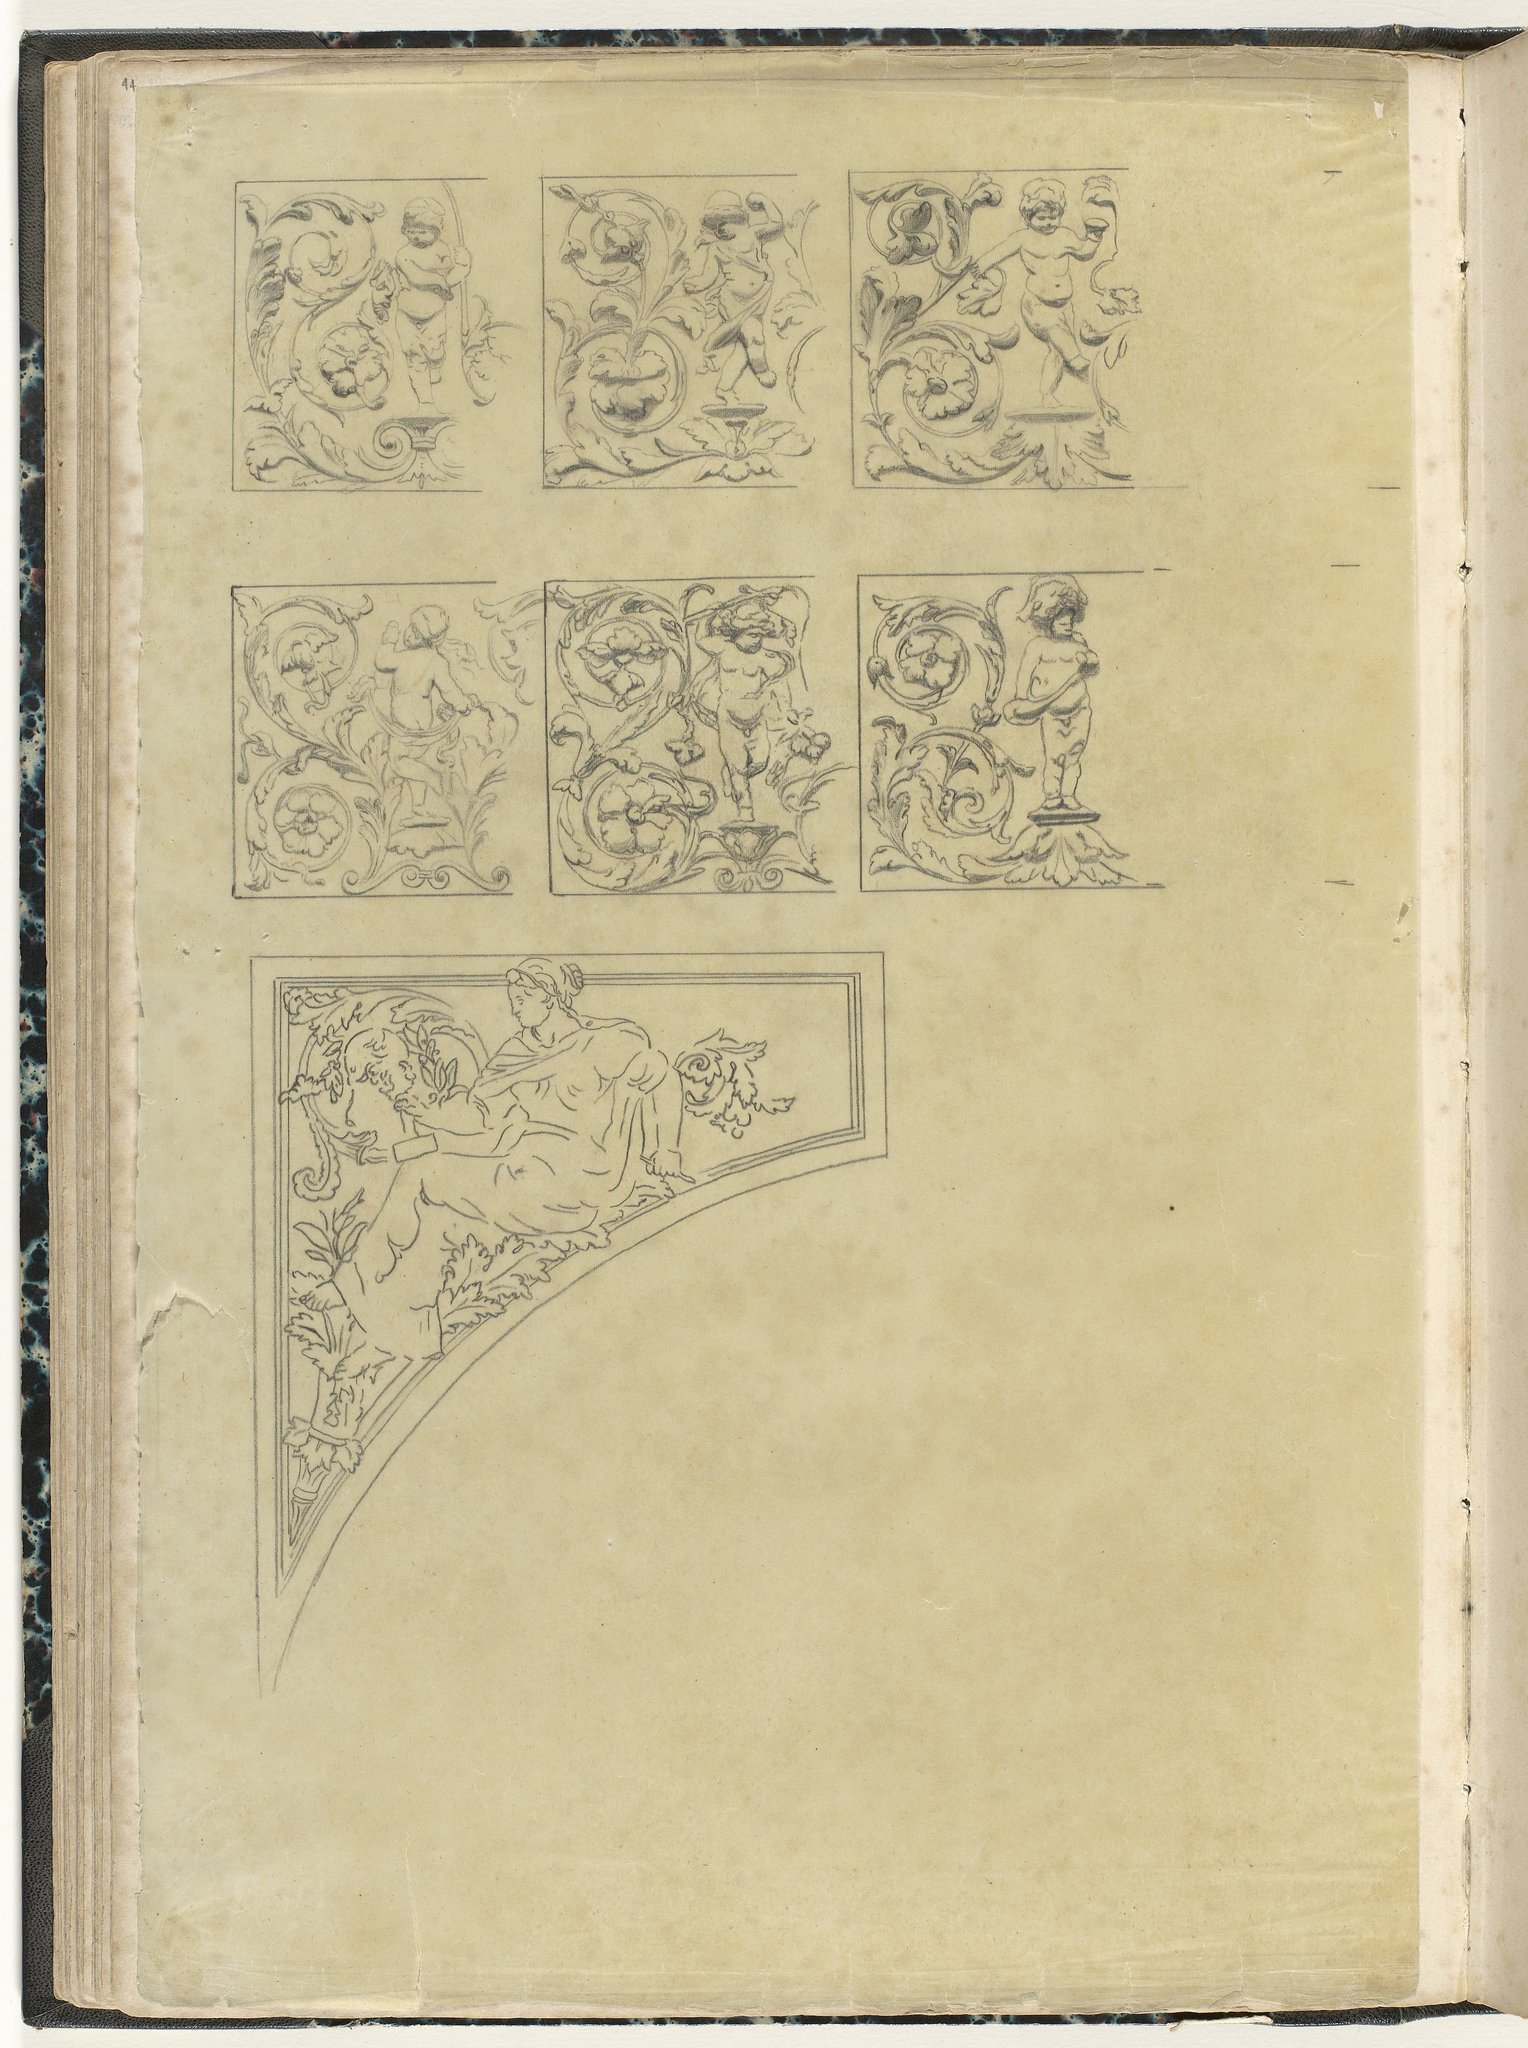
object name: drawing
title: Zes vlakdecoraties en zwik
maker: Anonymous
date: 1866-1900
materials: pencil, paper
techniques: drawing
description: Zes gedeeltelijk afgebeelde vlakdecoraties met putti tussen bladranken, daaronder een zwik met een persoon tussen bladranken.